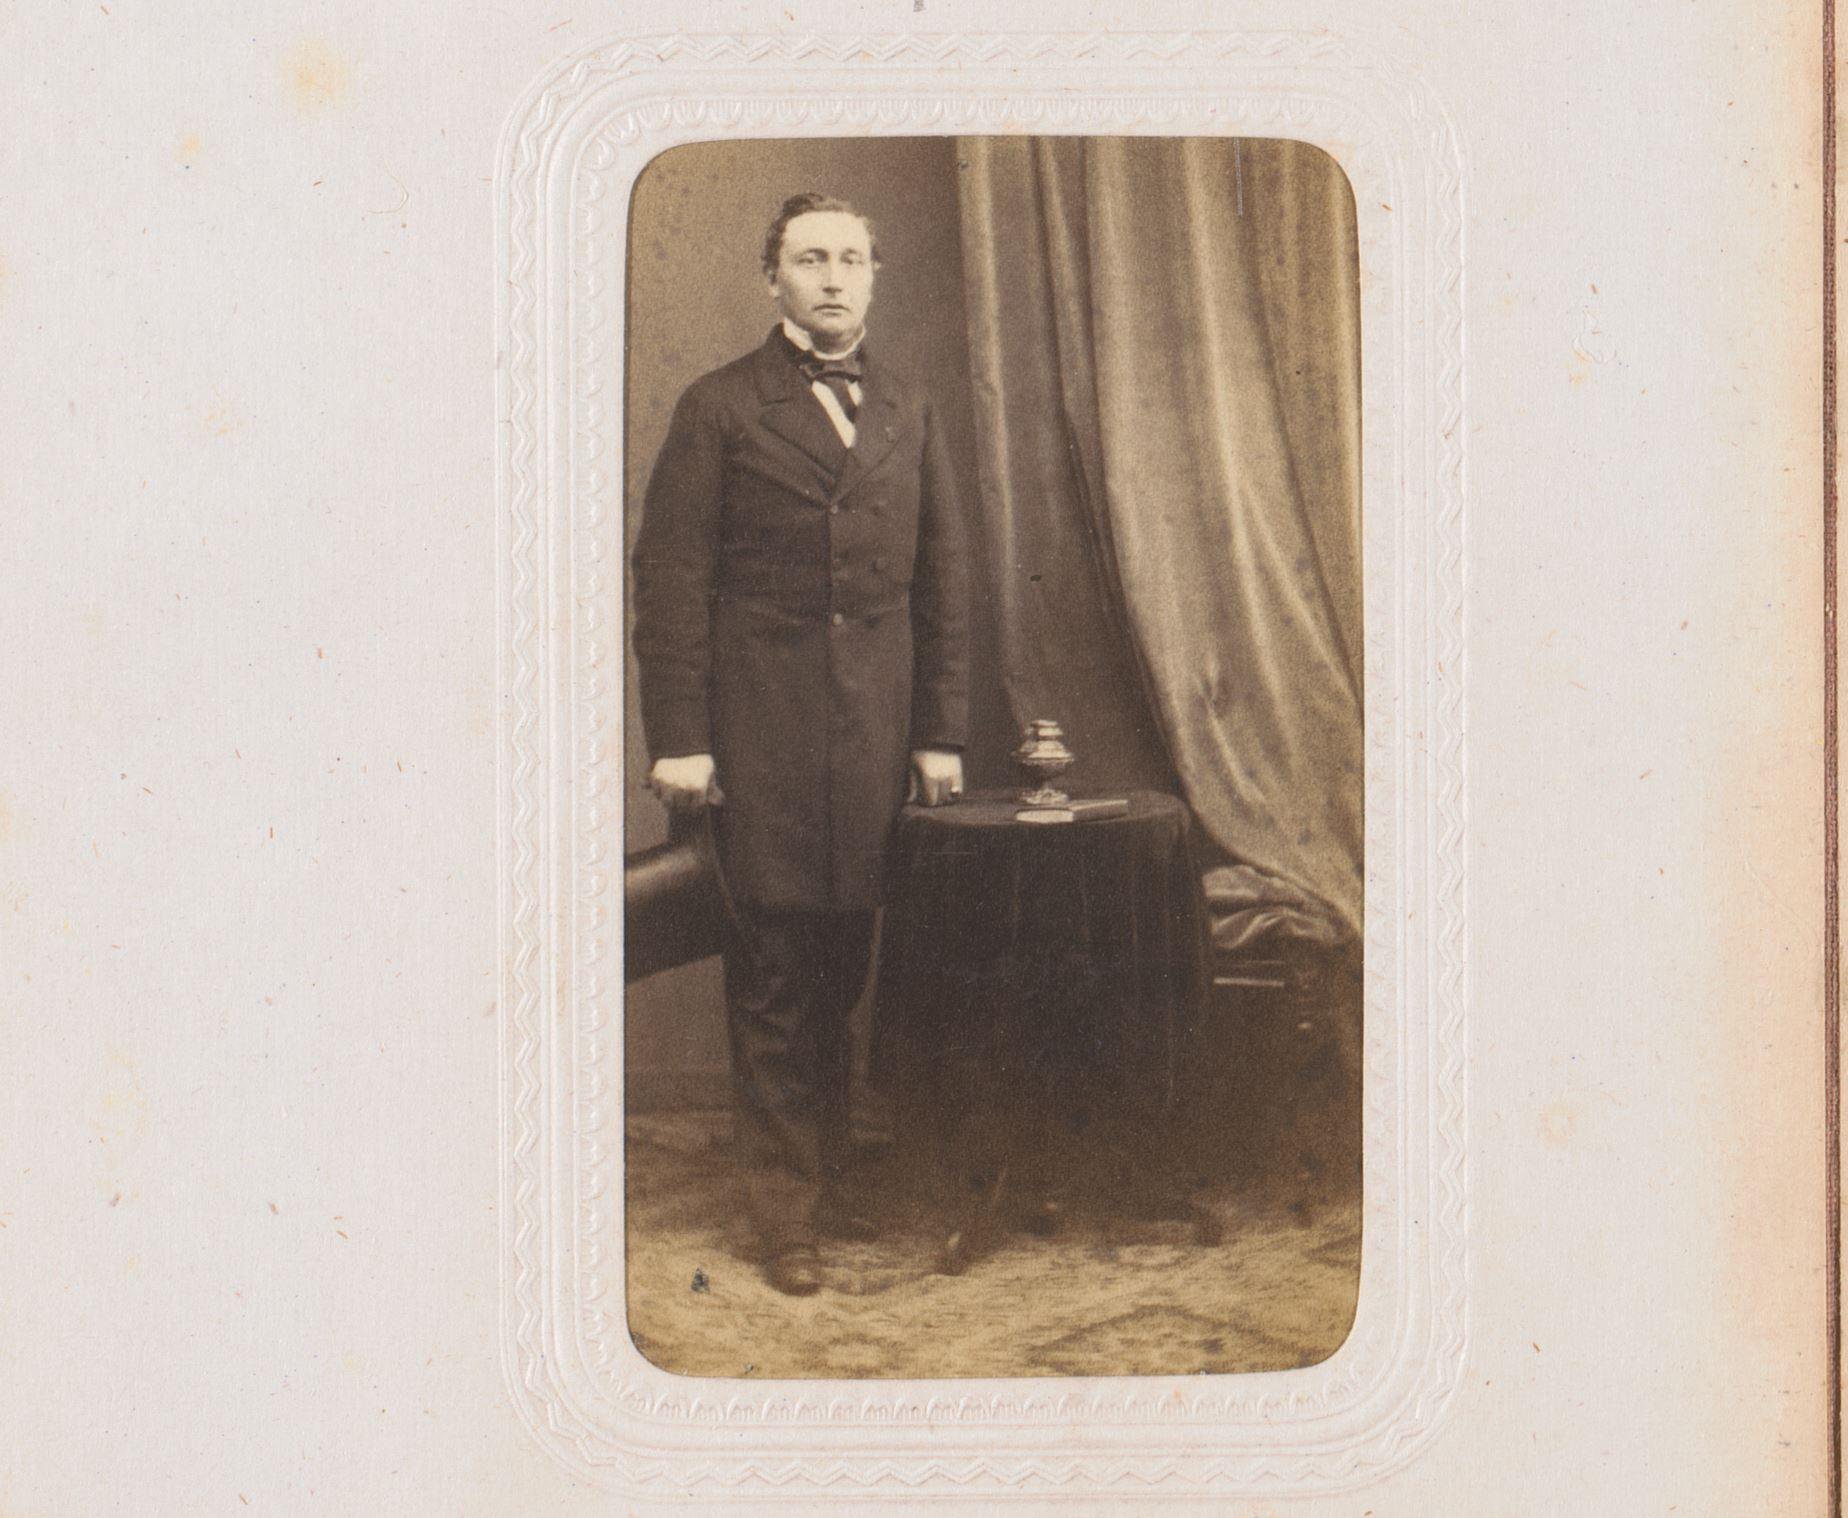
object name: photograph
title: Portret van Joost van Vollenhoven met hoed in de hand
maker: maurits verveer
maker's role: painter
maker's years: 1817-1903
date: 1861-1883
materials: cardboard, photographic support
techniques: albumen print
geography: the hague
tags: rotterdam, mayor, historical persons, head-gear: hat, politician, e.g. party leader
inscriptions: name: ‘Joost van Vollenhoven’, inscription: ‘M. VERVEER/ PHOTOGRAPHE/ DE S. M. LE ROI DES PAYS-BAS/ 52, ZEESTRAAT, 52/ VIS A VIS DU WILLEMSPARK/ LA HAYE.’, name: ‘Joost van Vollenhoven’